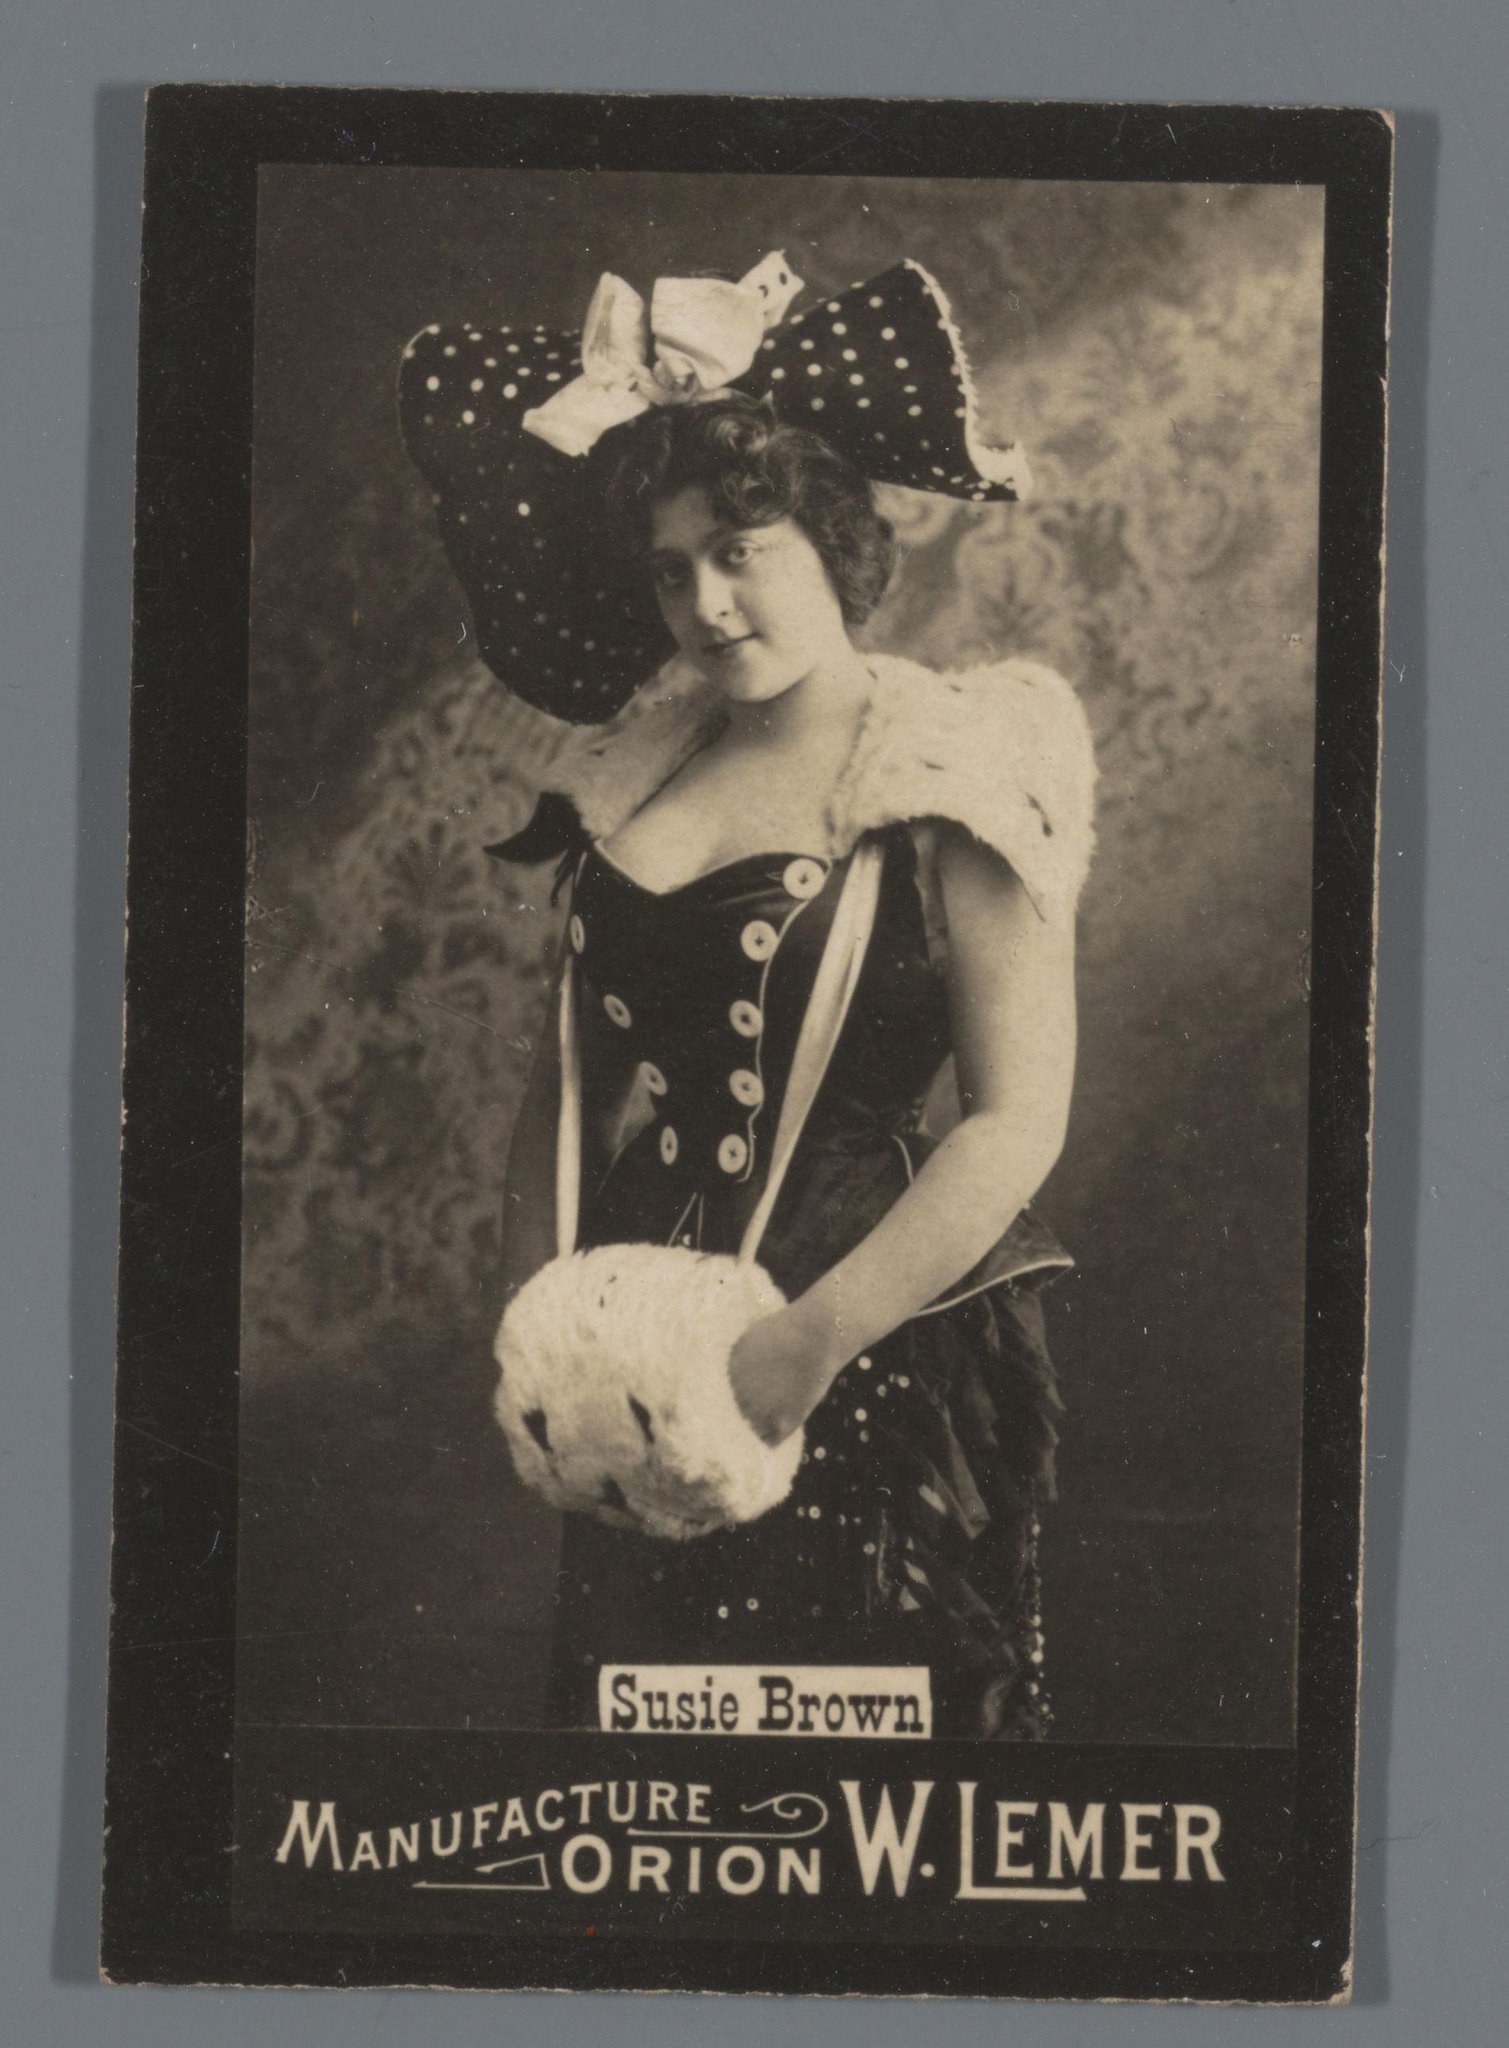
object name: photograph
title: Portret van Susie Brown met hoed en mof, reclame voor Orion W. Lemer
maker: Anonymous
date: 1890-1900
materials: photographic support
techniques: gelatin silver print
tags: historical persons - bb - woman, muff, head-gear: hat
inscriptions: inscription: ‘MANUFACTURE/ ORION W. LEMER’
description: Dergelijke foto's stonden bekend als 'zwartjes'. Men verkreeg ze bij aanschaf van bepaalde merken thee, cacao, sigaretten, beschuit, etc. om te verzamelen. Er waren speciaal voor de 'zwartjes' vervaardigde verzamelalbums in omloop.